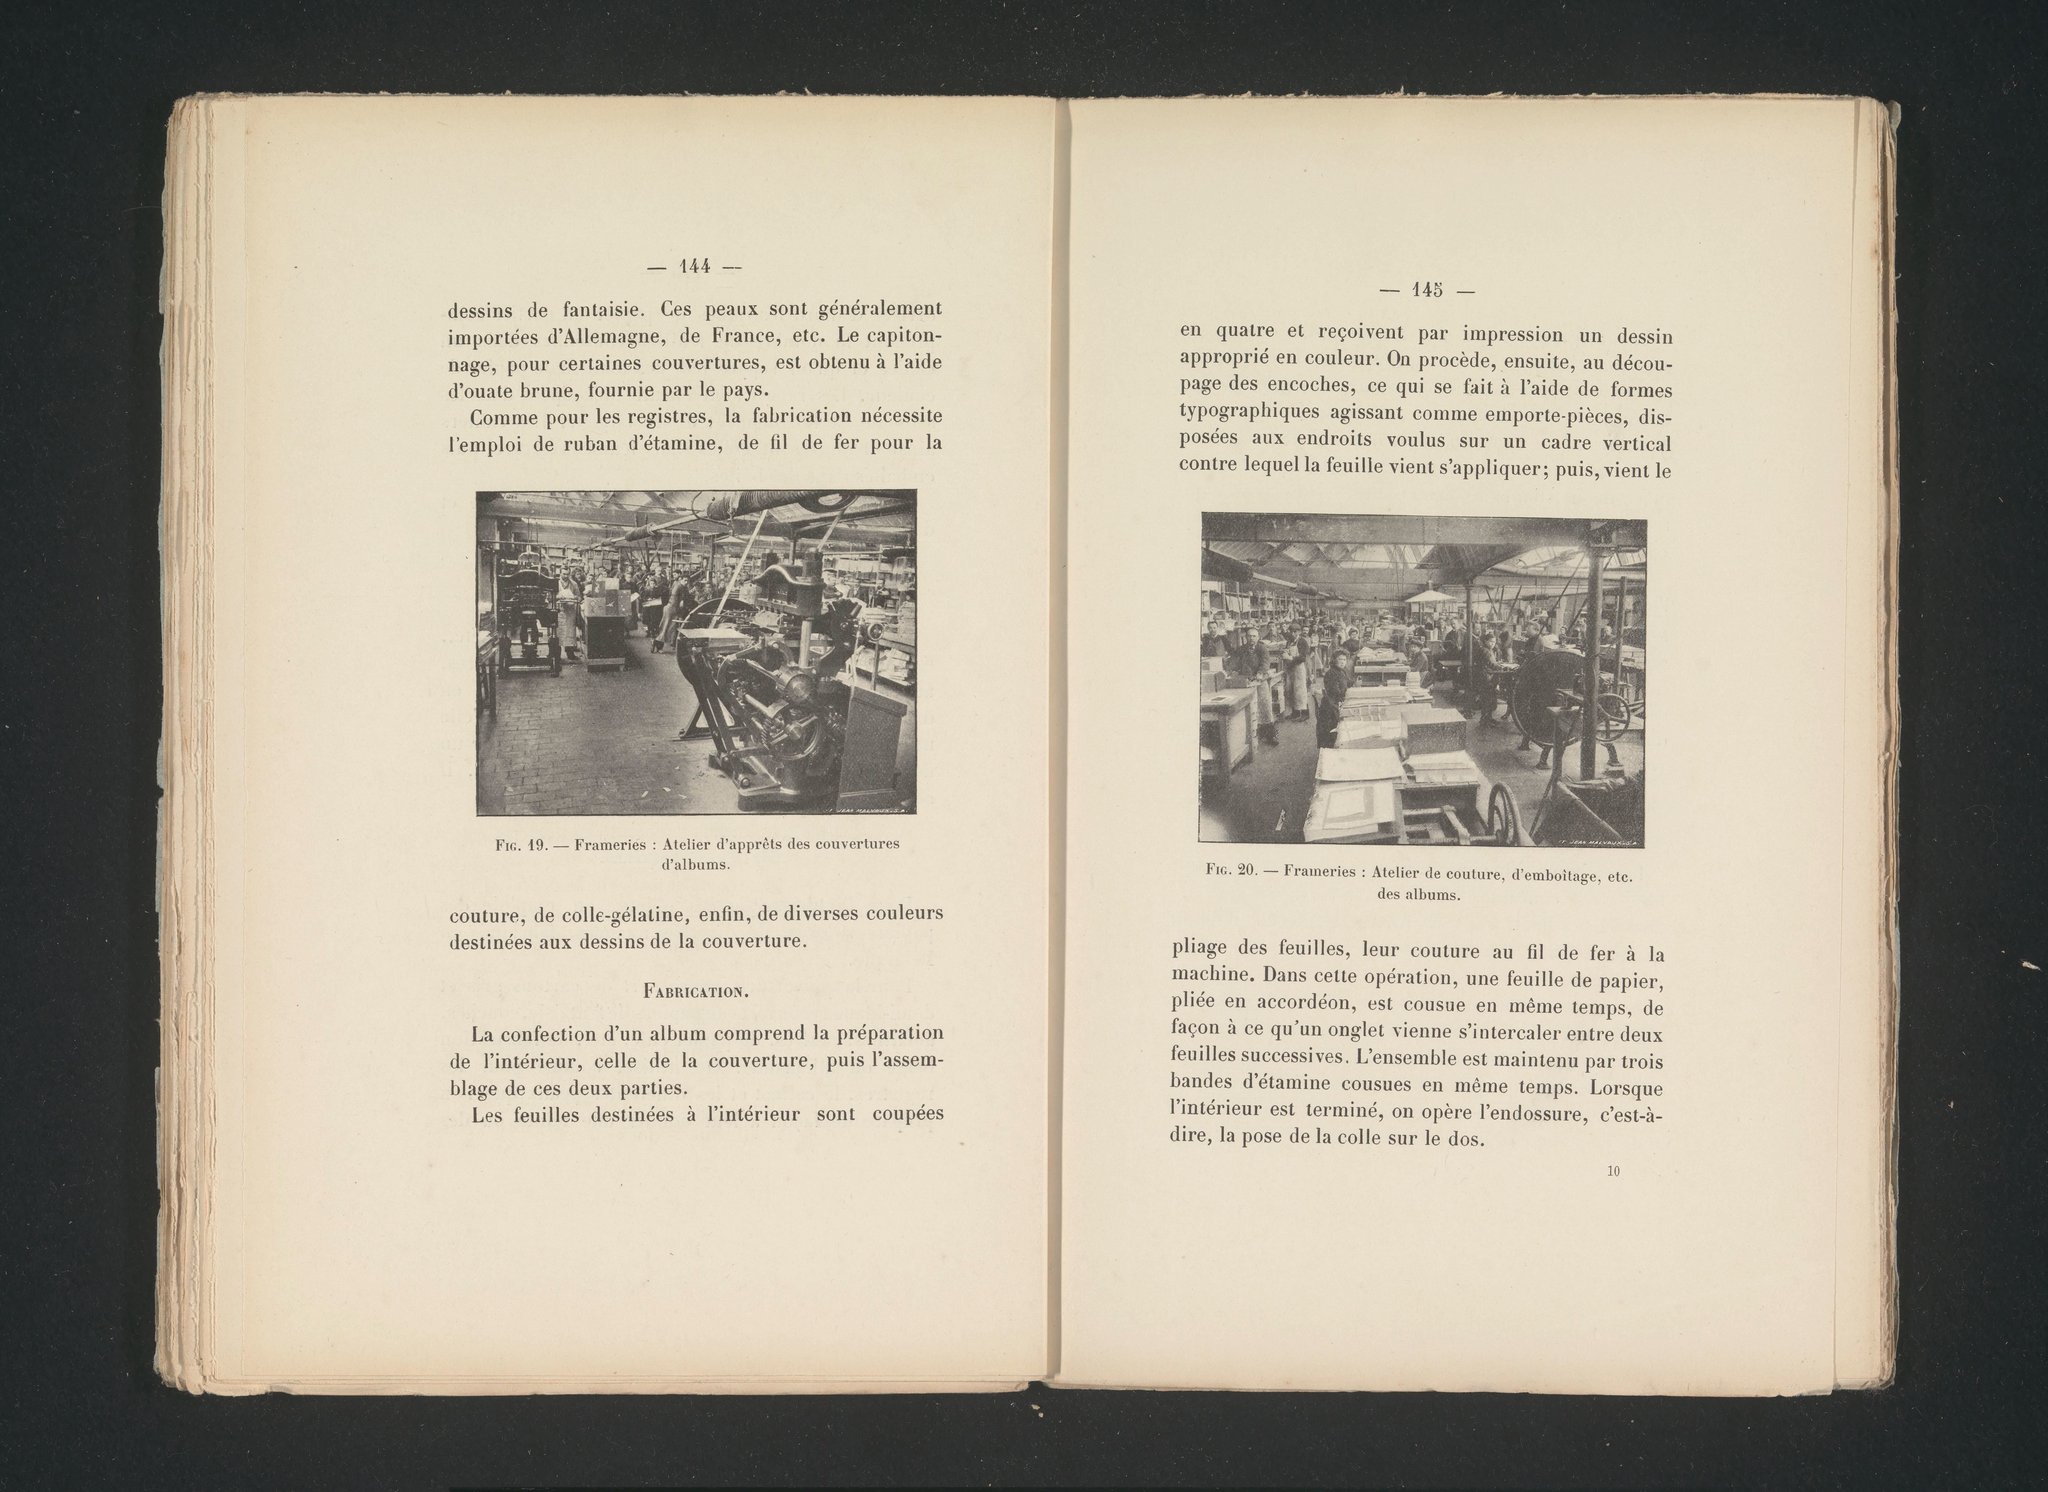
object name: photomechanical print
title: Gezicht op een werkplaats voor het snijden en inpakken van albums in Frameries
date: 1901-1906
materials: paper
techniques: autotype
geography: frameries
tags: printing, printing office, workshop-interior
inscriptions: inscription: ‘Fig. 20. - Frameries: Atelier de couture, d'emboîtage, etc. des albums.’